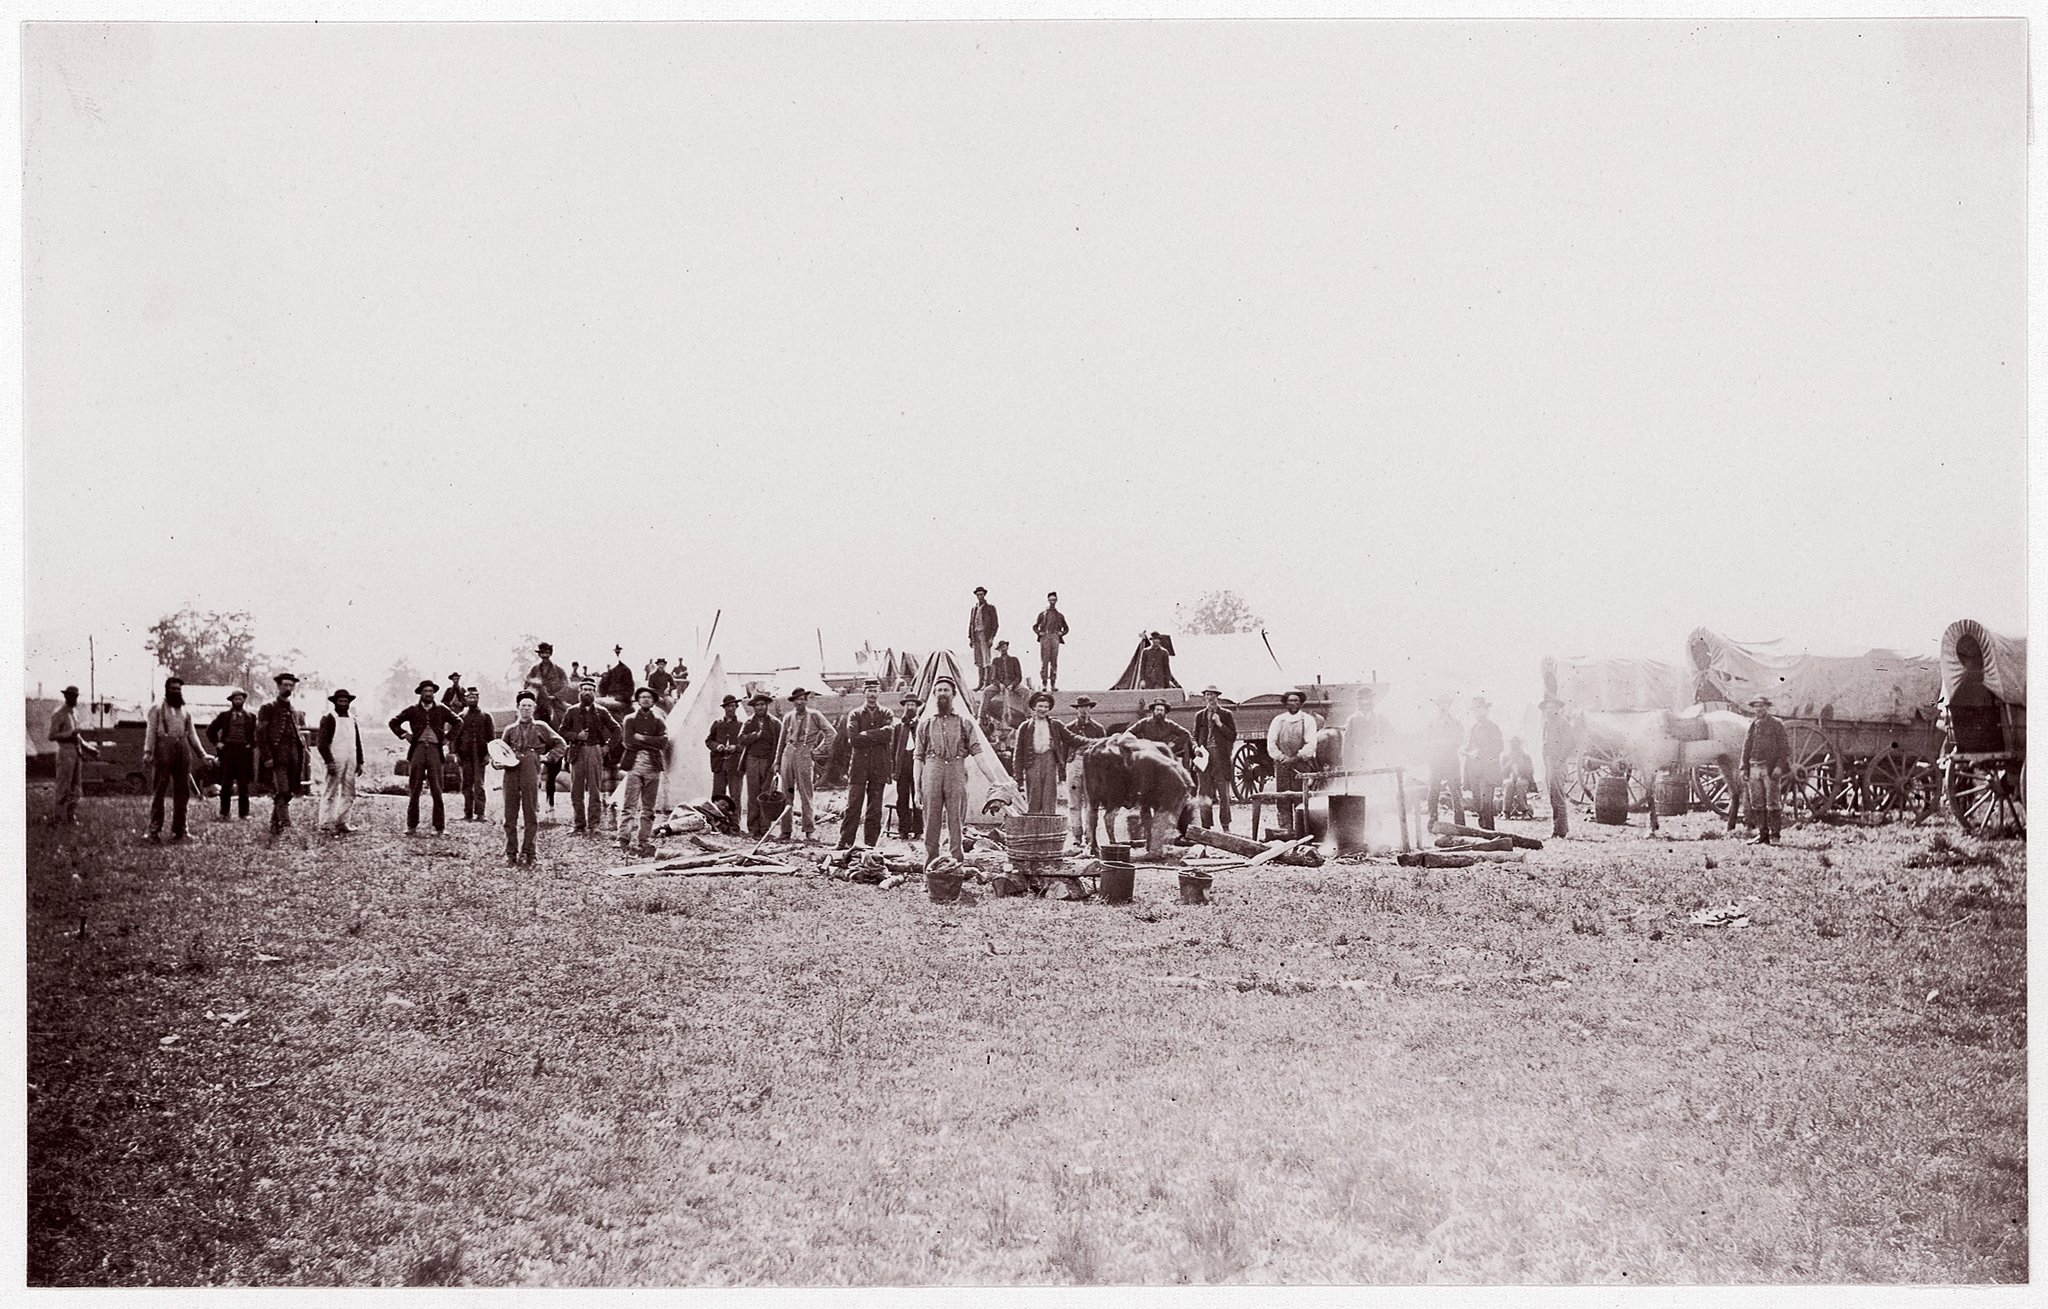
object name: photograph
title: [Unidentified Company of Soldiers and Civilians (?) in Field]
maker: Anonymous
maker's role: artist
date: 1861-1865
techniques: albumen silver print, glass negative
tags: soldiers,american civil war